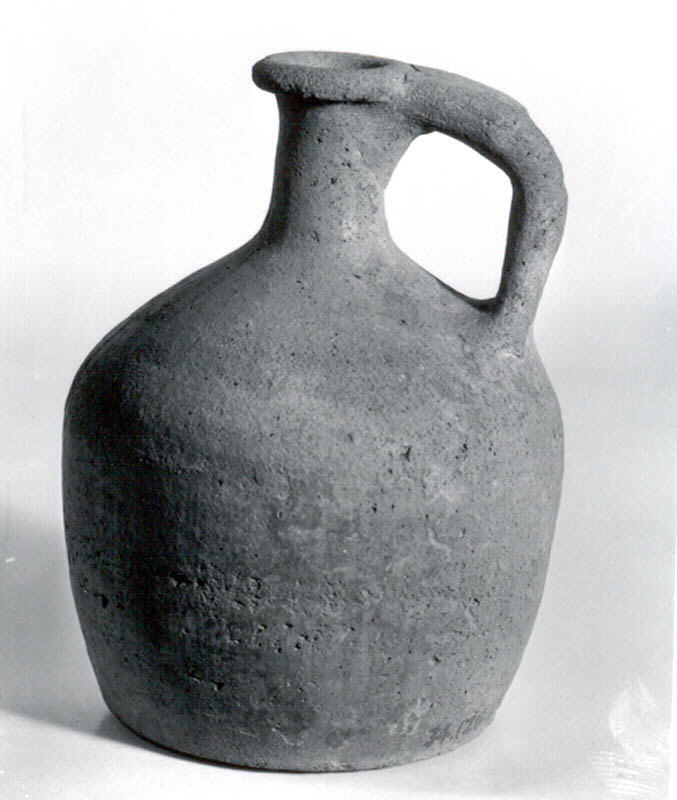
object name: jug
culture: canaanite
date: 1780-1580 BCE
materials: ceramic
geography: levant